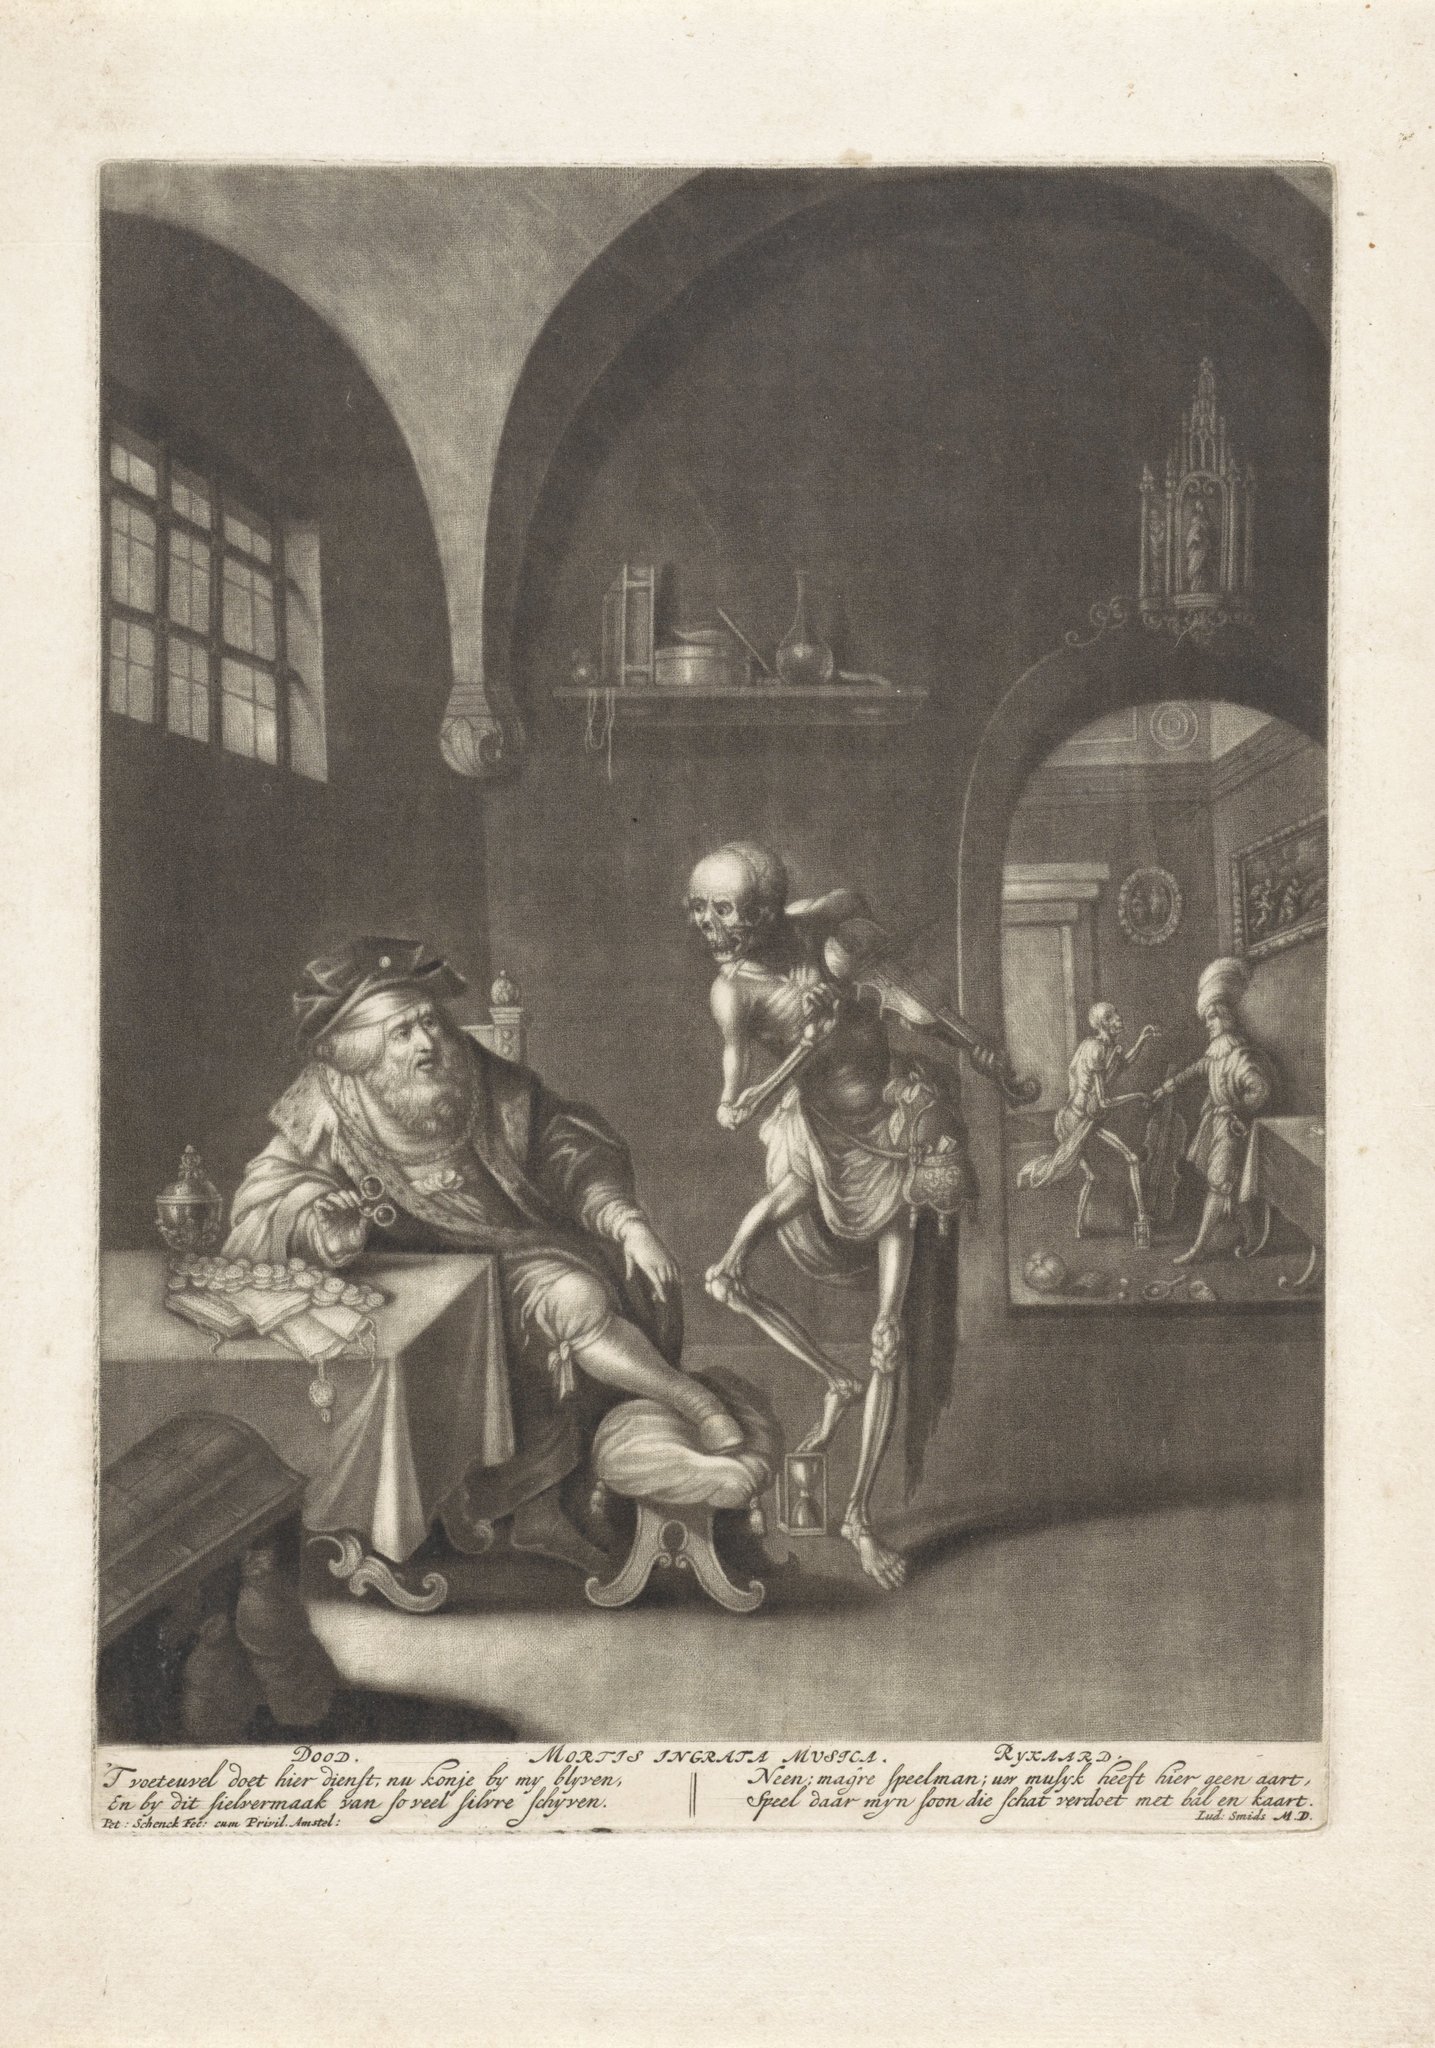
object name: print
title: Rijke man en de Dood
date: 1670-1713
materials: paper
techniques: engraving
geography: amsterdam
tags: one person playing string instrument (bowed), death as old man, violin, fiddle, greed, covetousness, cupidity; 'cupidità' (ripa), old man, miser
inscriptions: collector's mark: Lugt 2760, collector's mark: Lugt 2166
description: Een rijke man zit met kisten en zakken vol geld aan een tafel. De dood staat voor hem viool te spelen en laat zijn voet rusten op een zandloper. Op de achtergrond verspilt de zoon van de rijkaard zijn geld en tijd met spelen. Uit het gedicht onder de prent blijkt dat de rijkaard de dood naar zijn zoon stuurt.